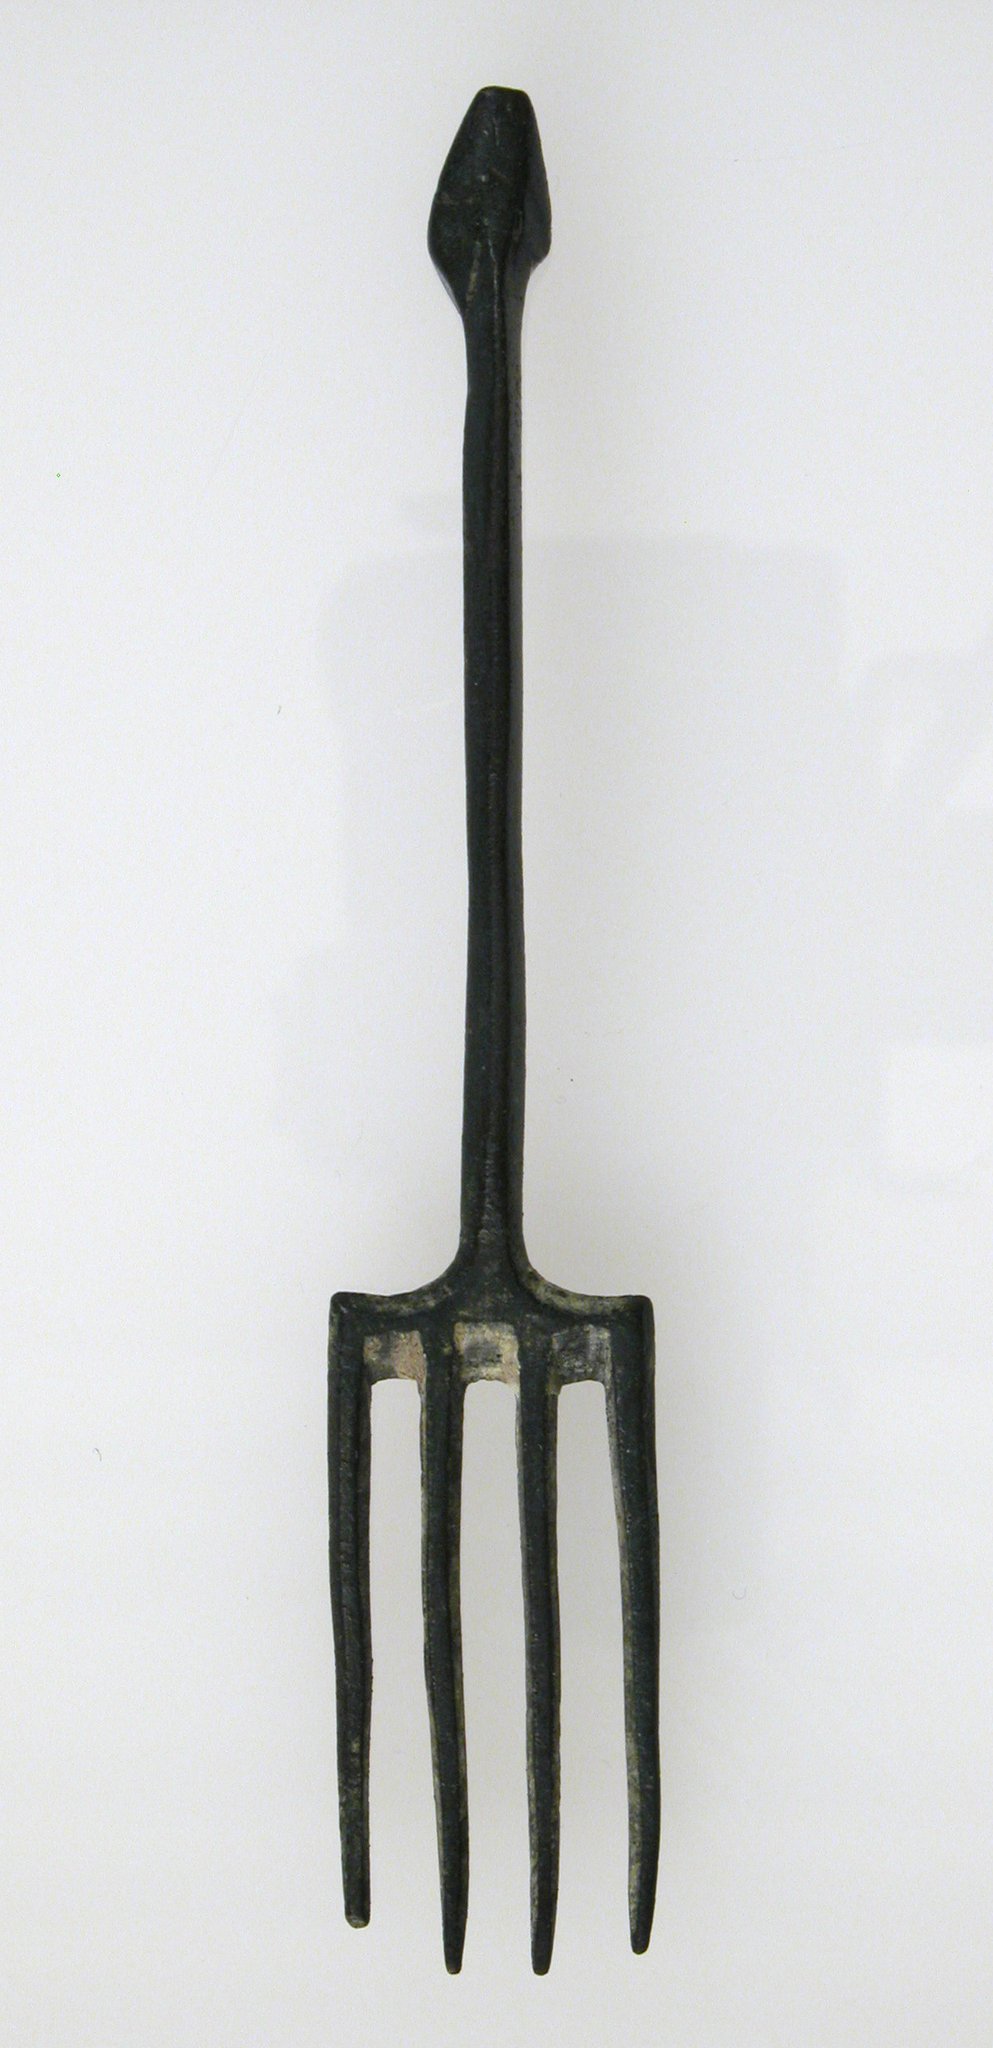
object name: fork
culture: roman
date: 1-400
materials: copper alloy